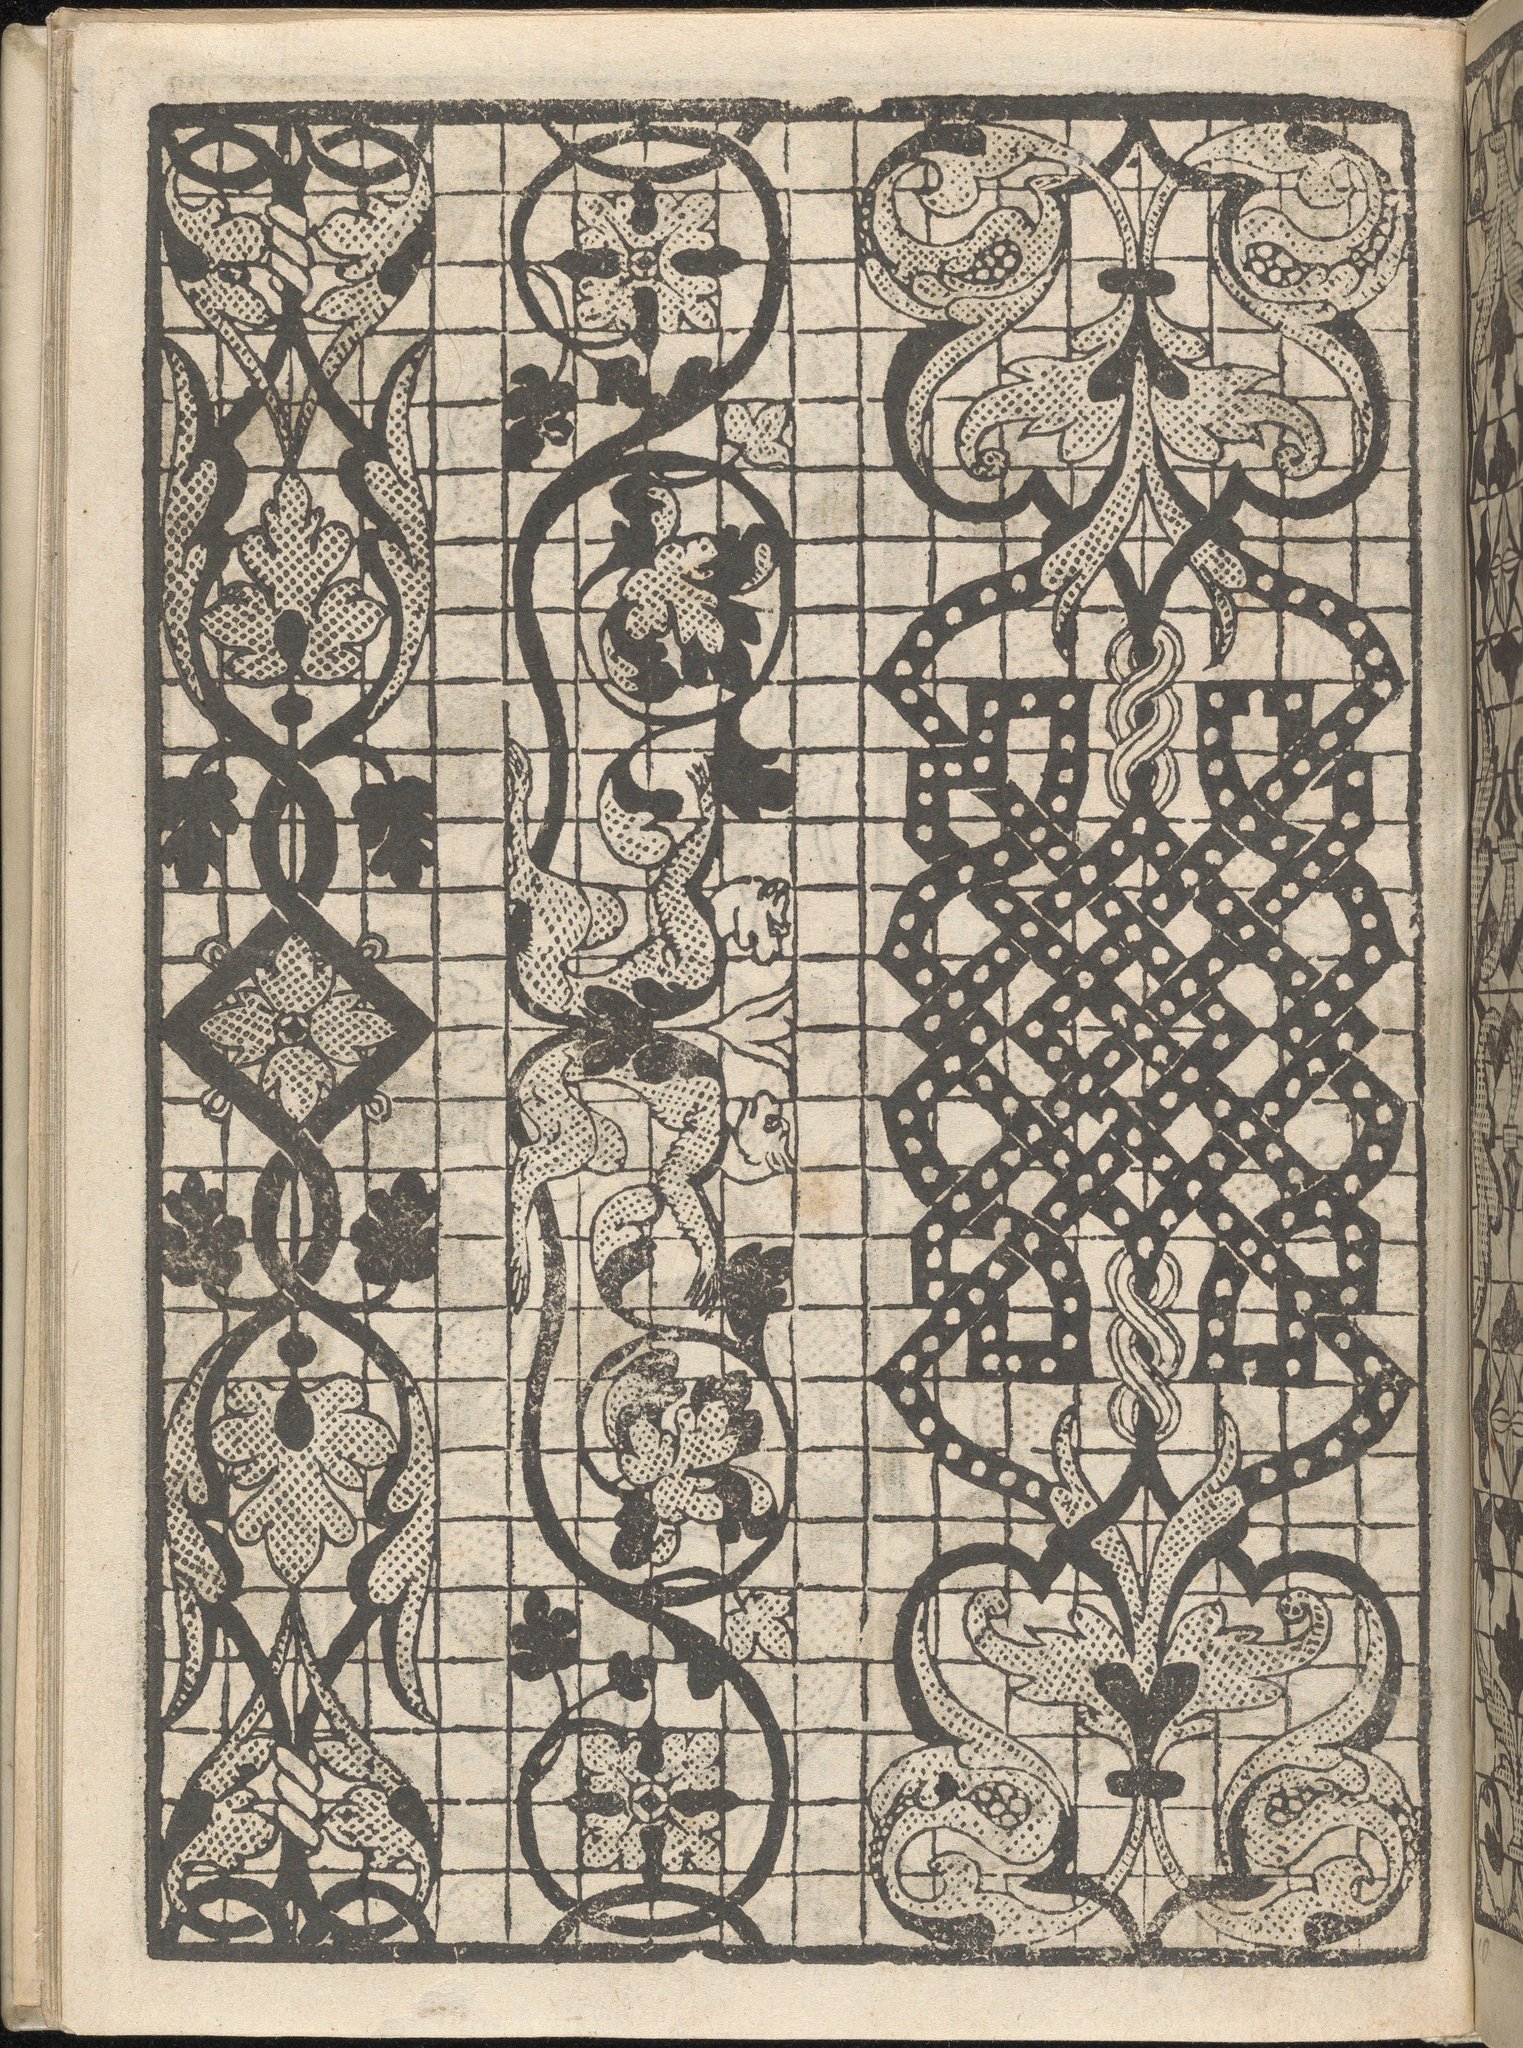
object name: book print ornament architecture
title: Splendore delle virtuose giovani, page 9 (verso)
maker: iseppo foresto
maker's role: designer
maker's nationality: italian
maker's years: 1520-1580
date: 1564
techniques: woodcut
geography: italy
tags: flowers,vines